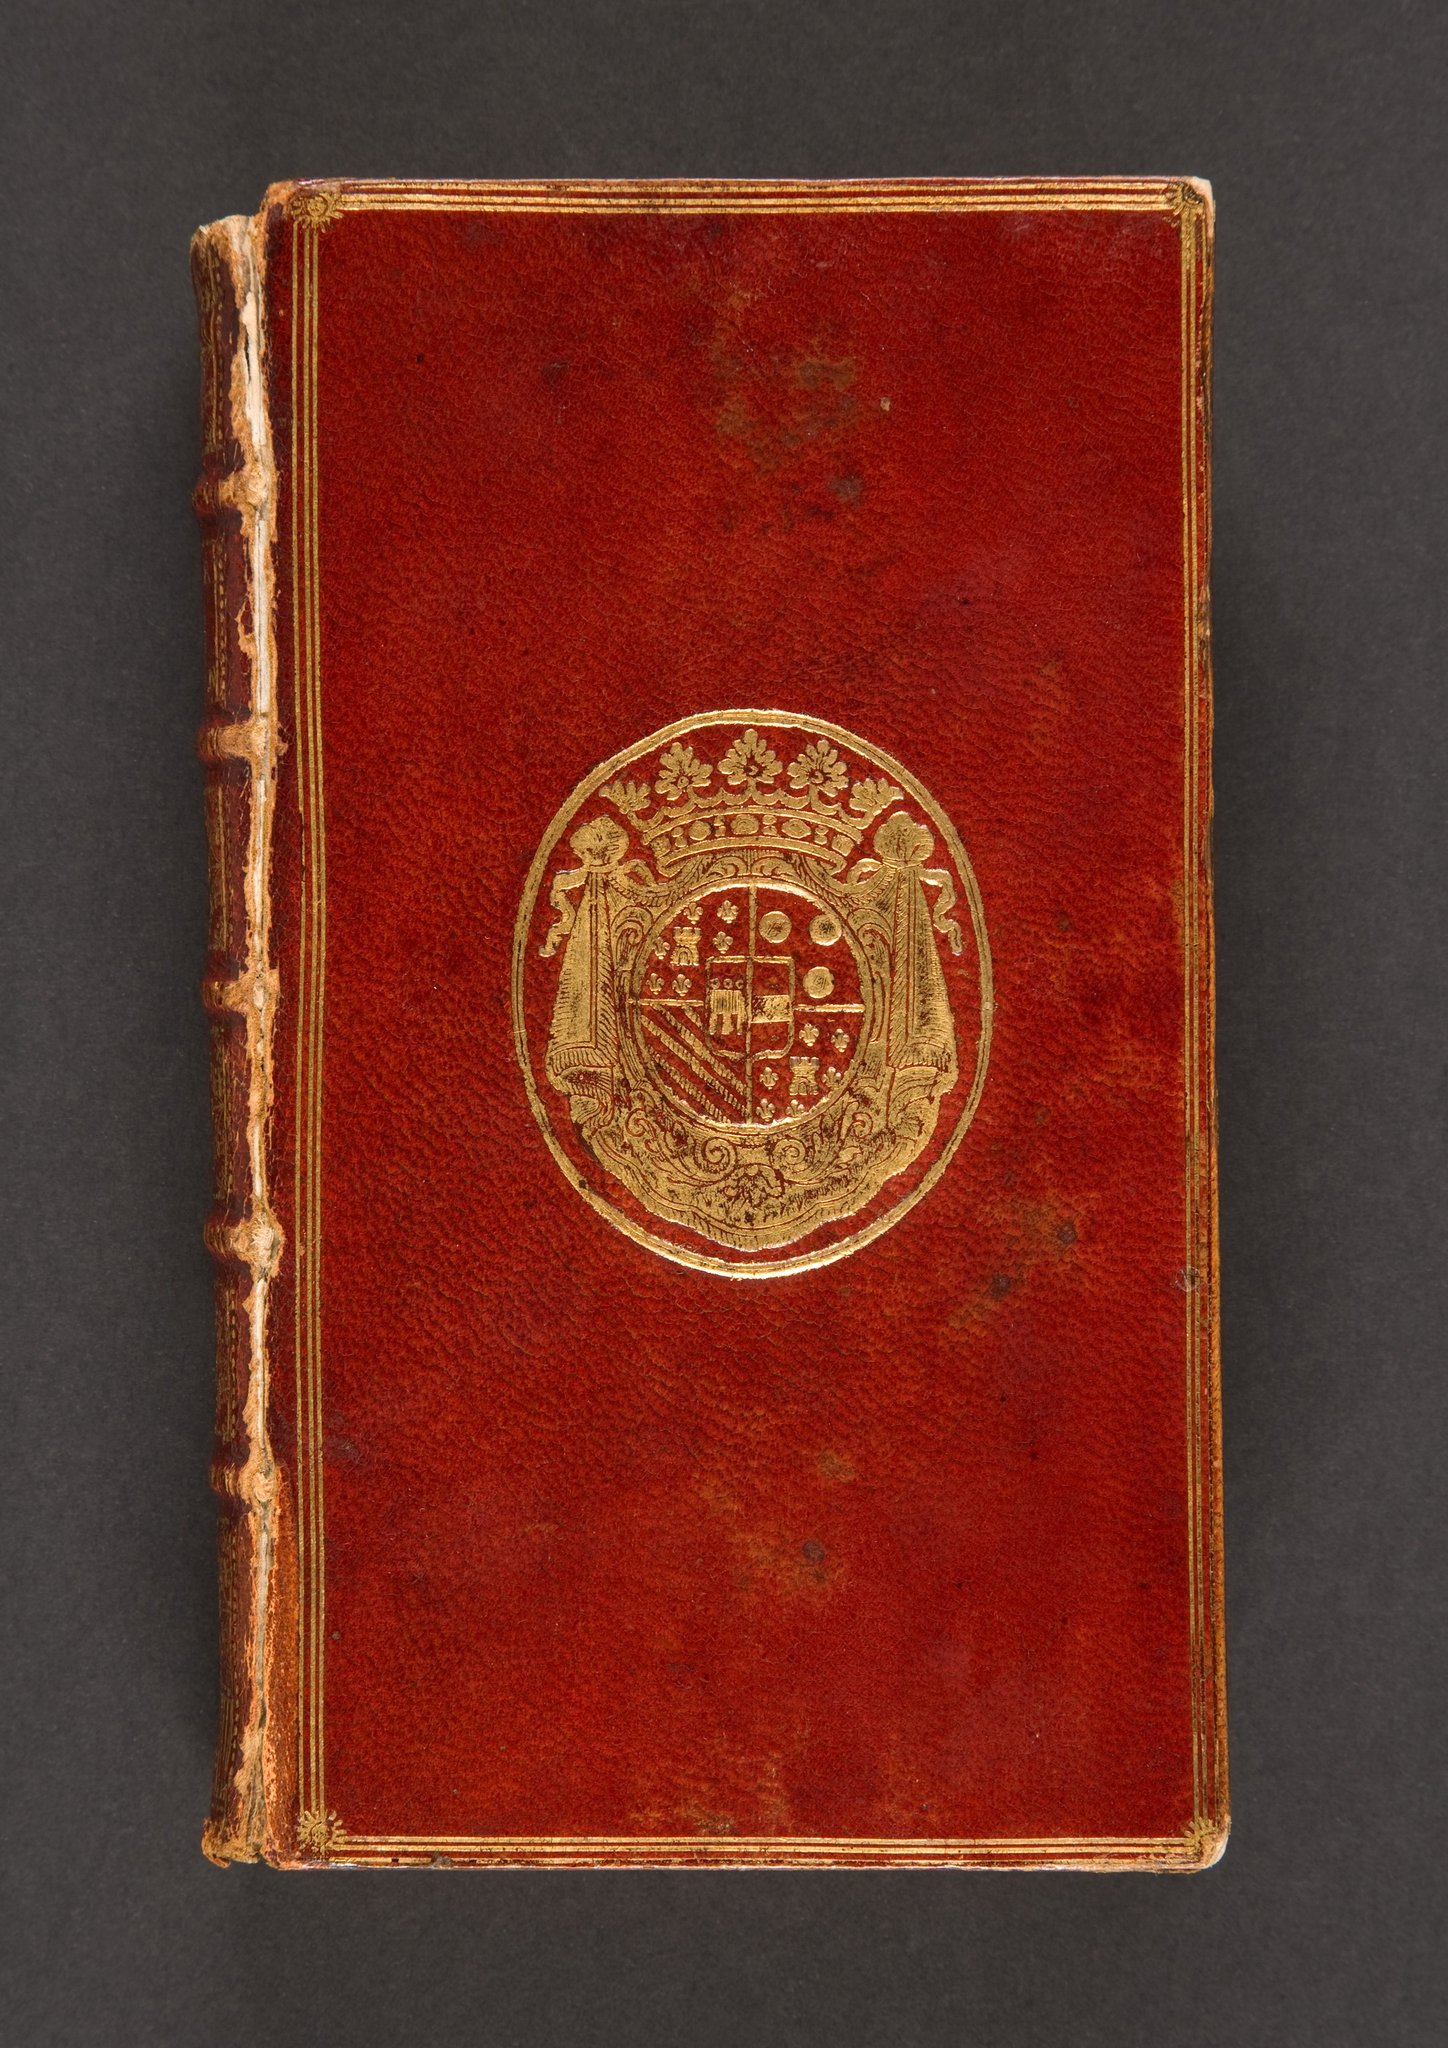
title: Histoire secrette de Neron, ov, Le festin de Trimalcion, traduit de Petrone, avec des notes historiques par M. Lavaur ...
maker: m. (guillaume de) lavaur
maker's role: author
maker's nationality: french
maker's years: 1653-1730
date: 1726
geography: france